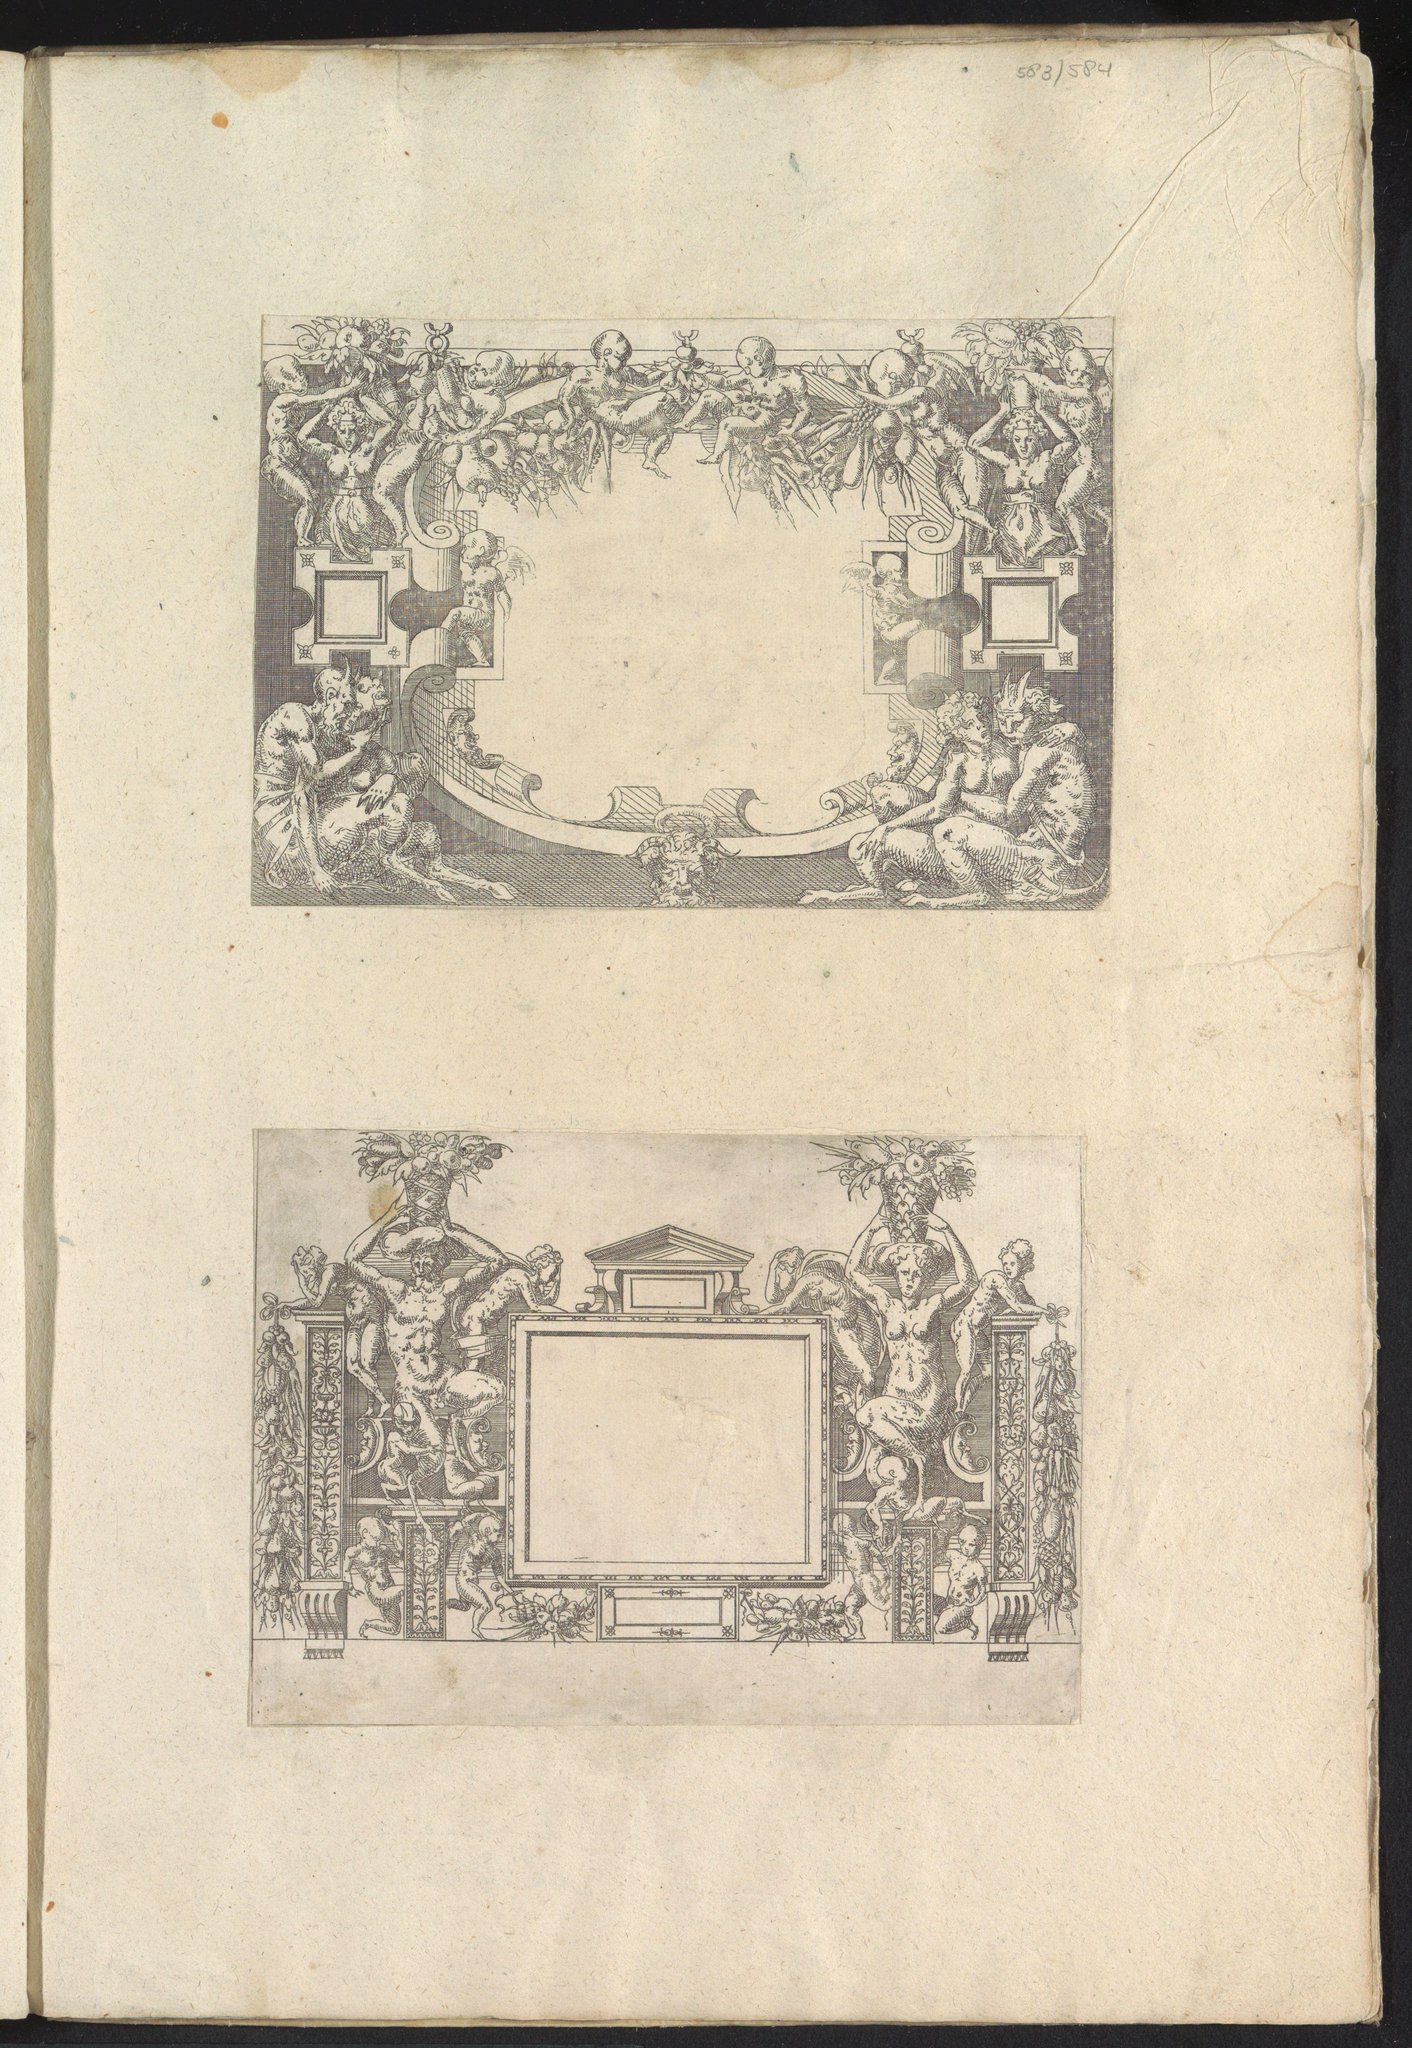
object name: album leaf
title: Albumblad met twee prenten van cartouches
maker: Anonymous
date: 1500-1599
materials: paper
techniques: etching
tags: ornament ~ cartouche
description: Albumblad met twee uitgeknipte prenten met ornamentele cartouches.